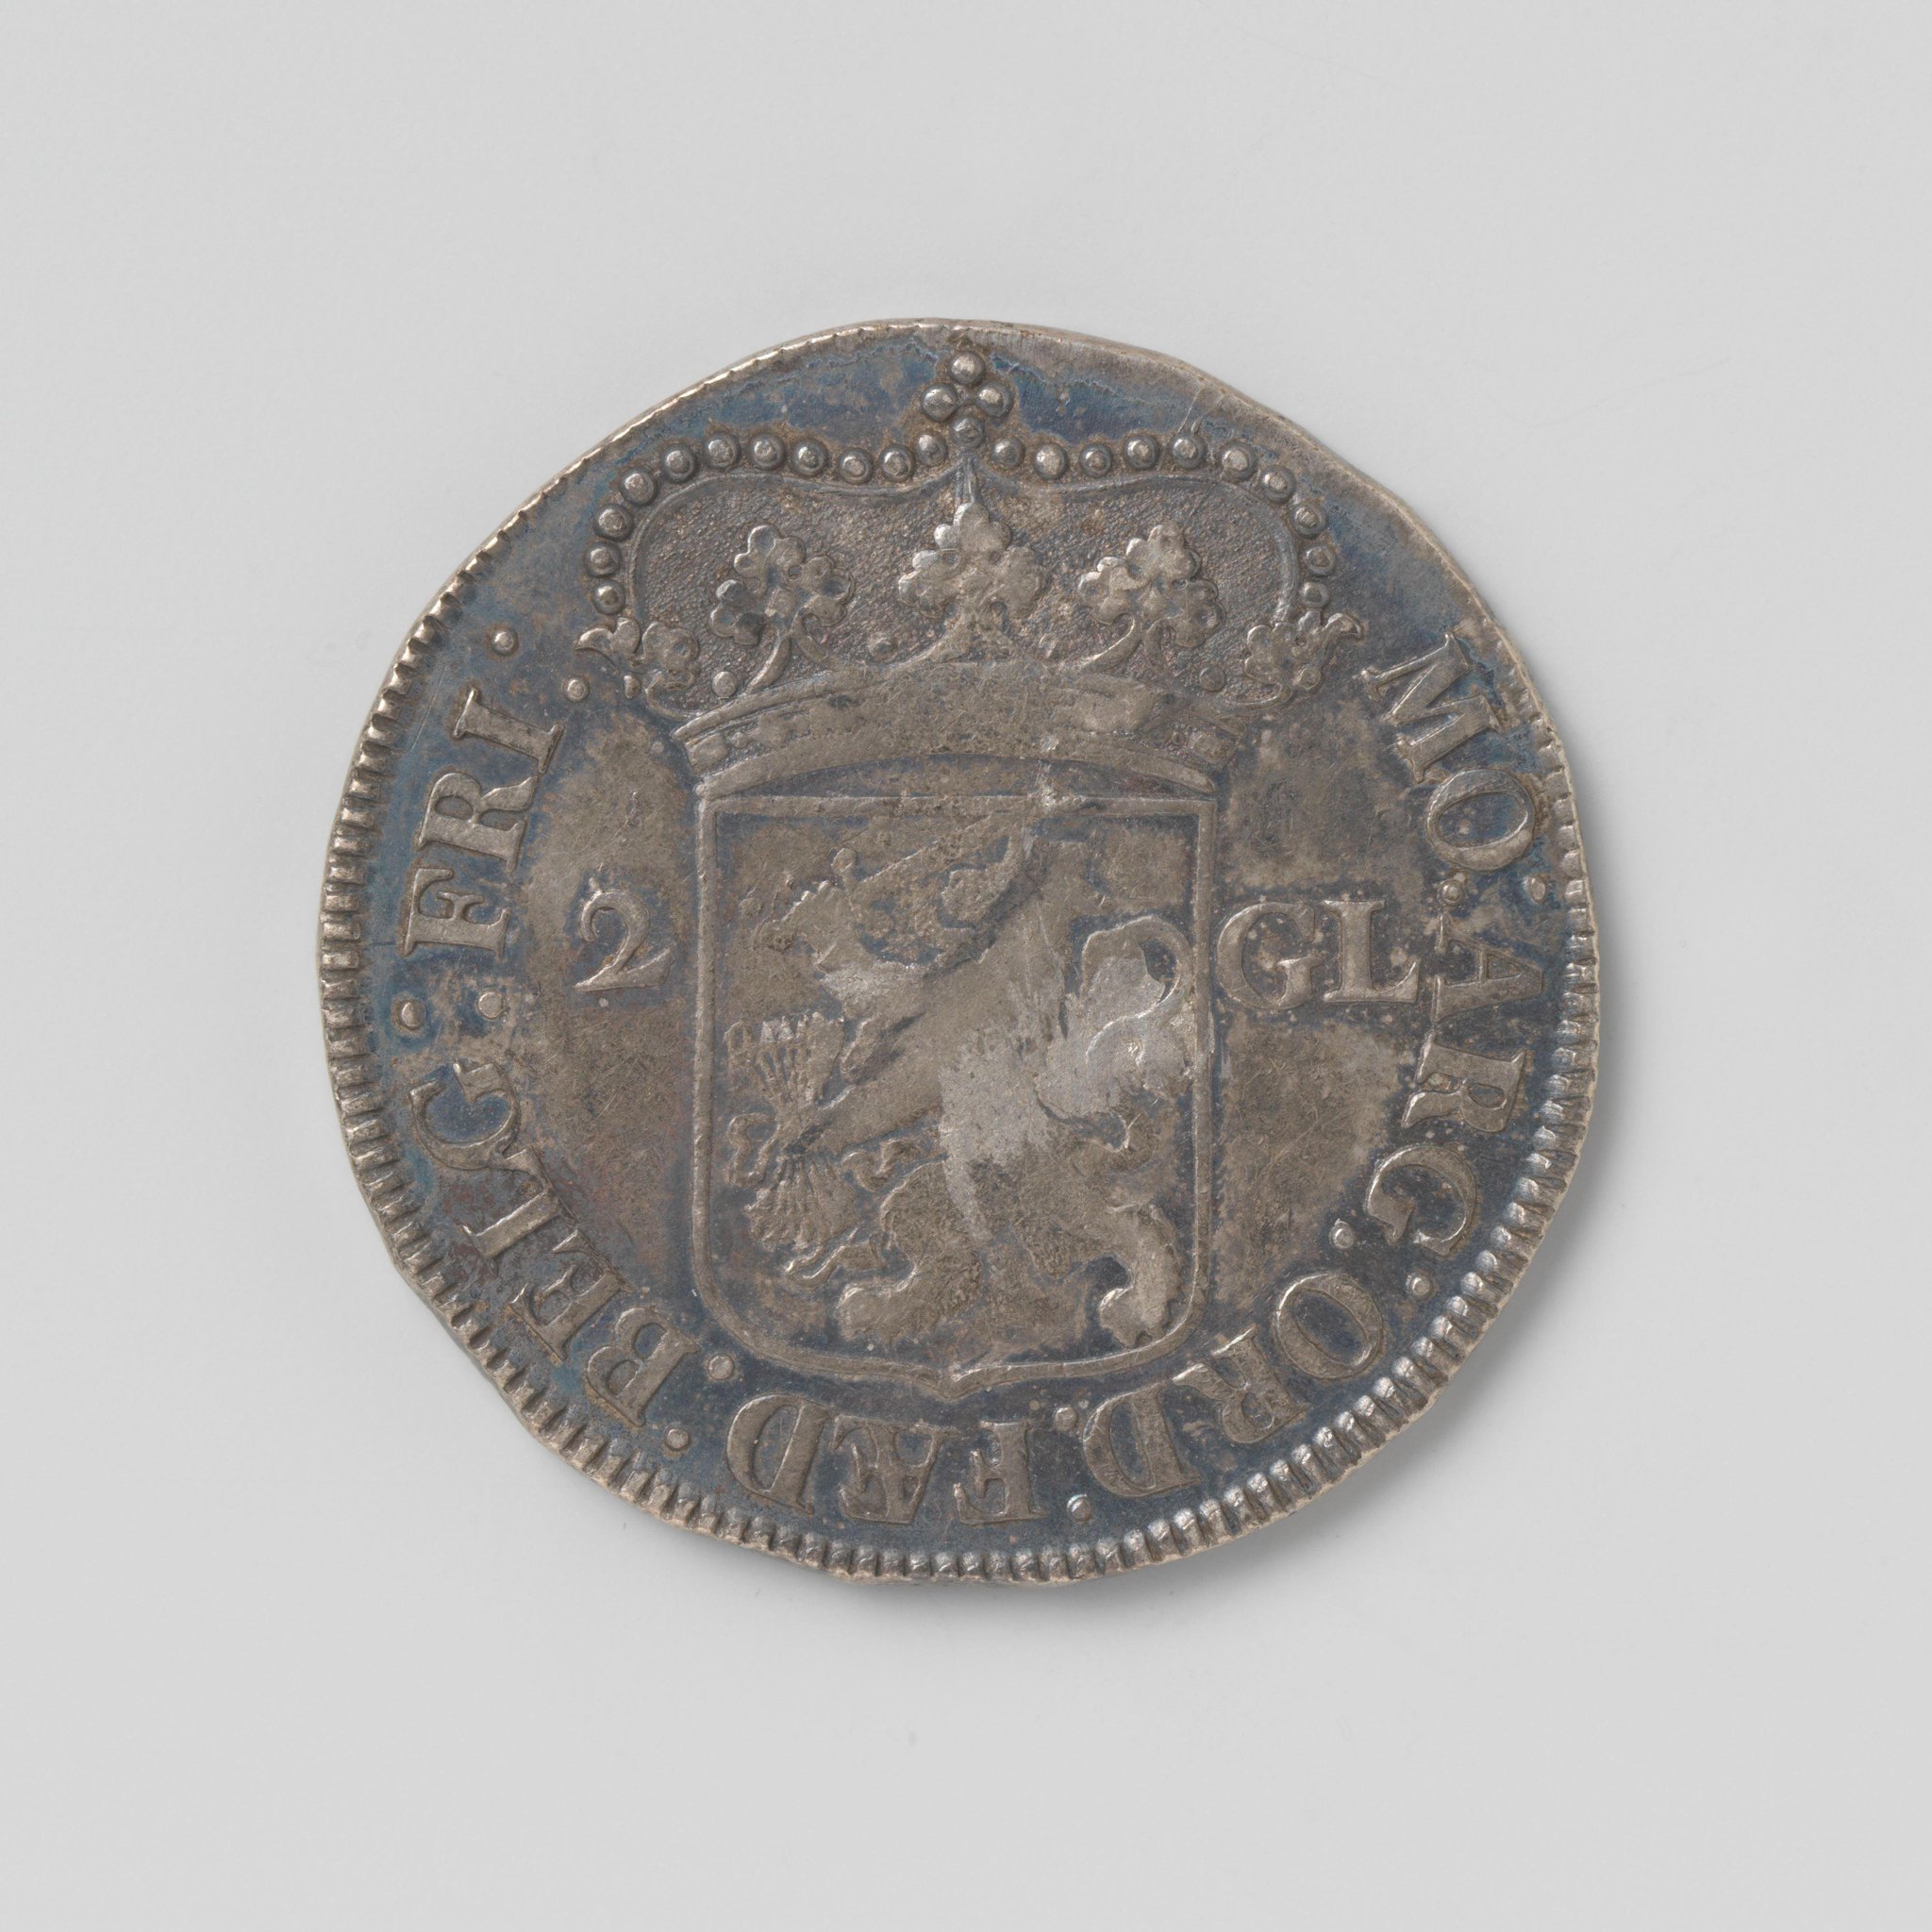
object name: coin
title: Friesland, twee gulden, 1696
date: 1696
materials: silver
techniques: striking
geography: leeuwarden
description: Zilveren munt. Voorzijde: tussen waarde-aanduiding gekroond generaliteitswapenschild. Keerzijde: staande Nederlandse maagd met in rechterhand speer, waarop hoed, met linkerhand steunend op een altaar, waarop bijbel. In afsnede jaartal.